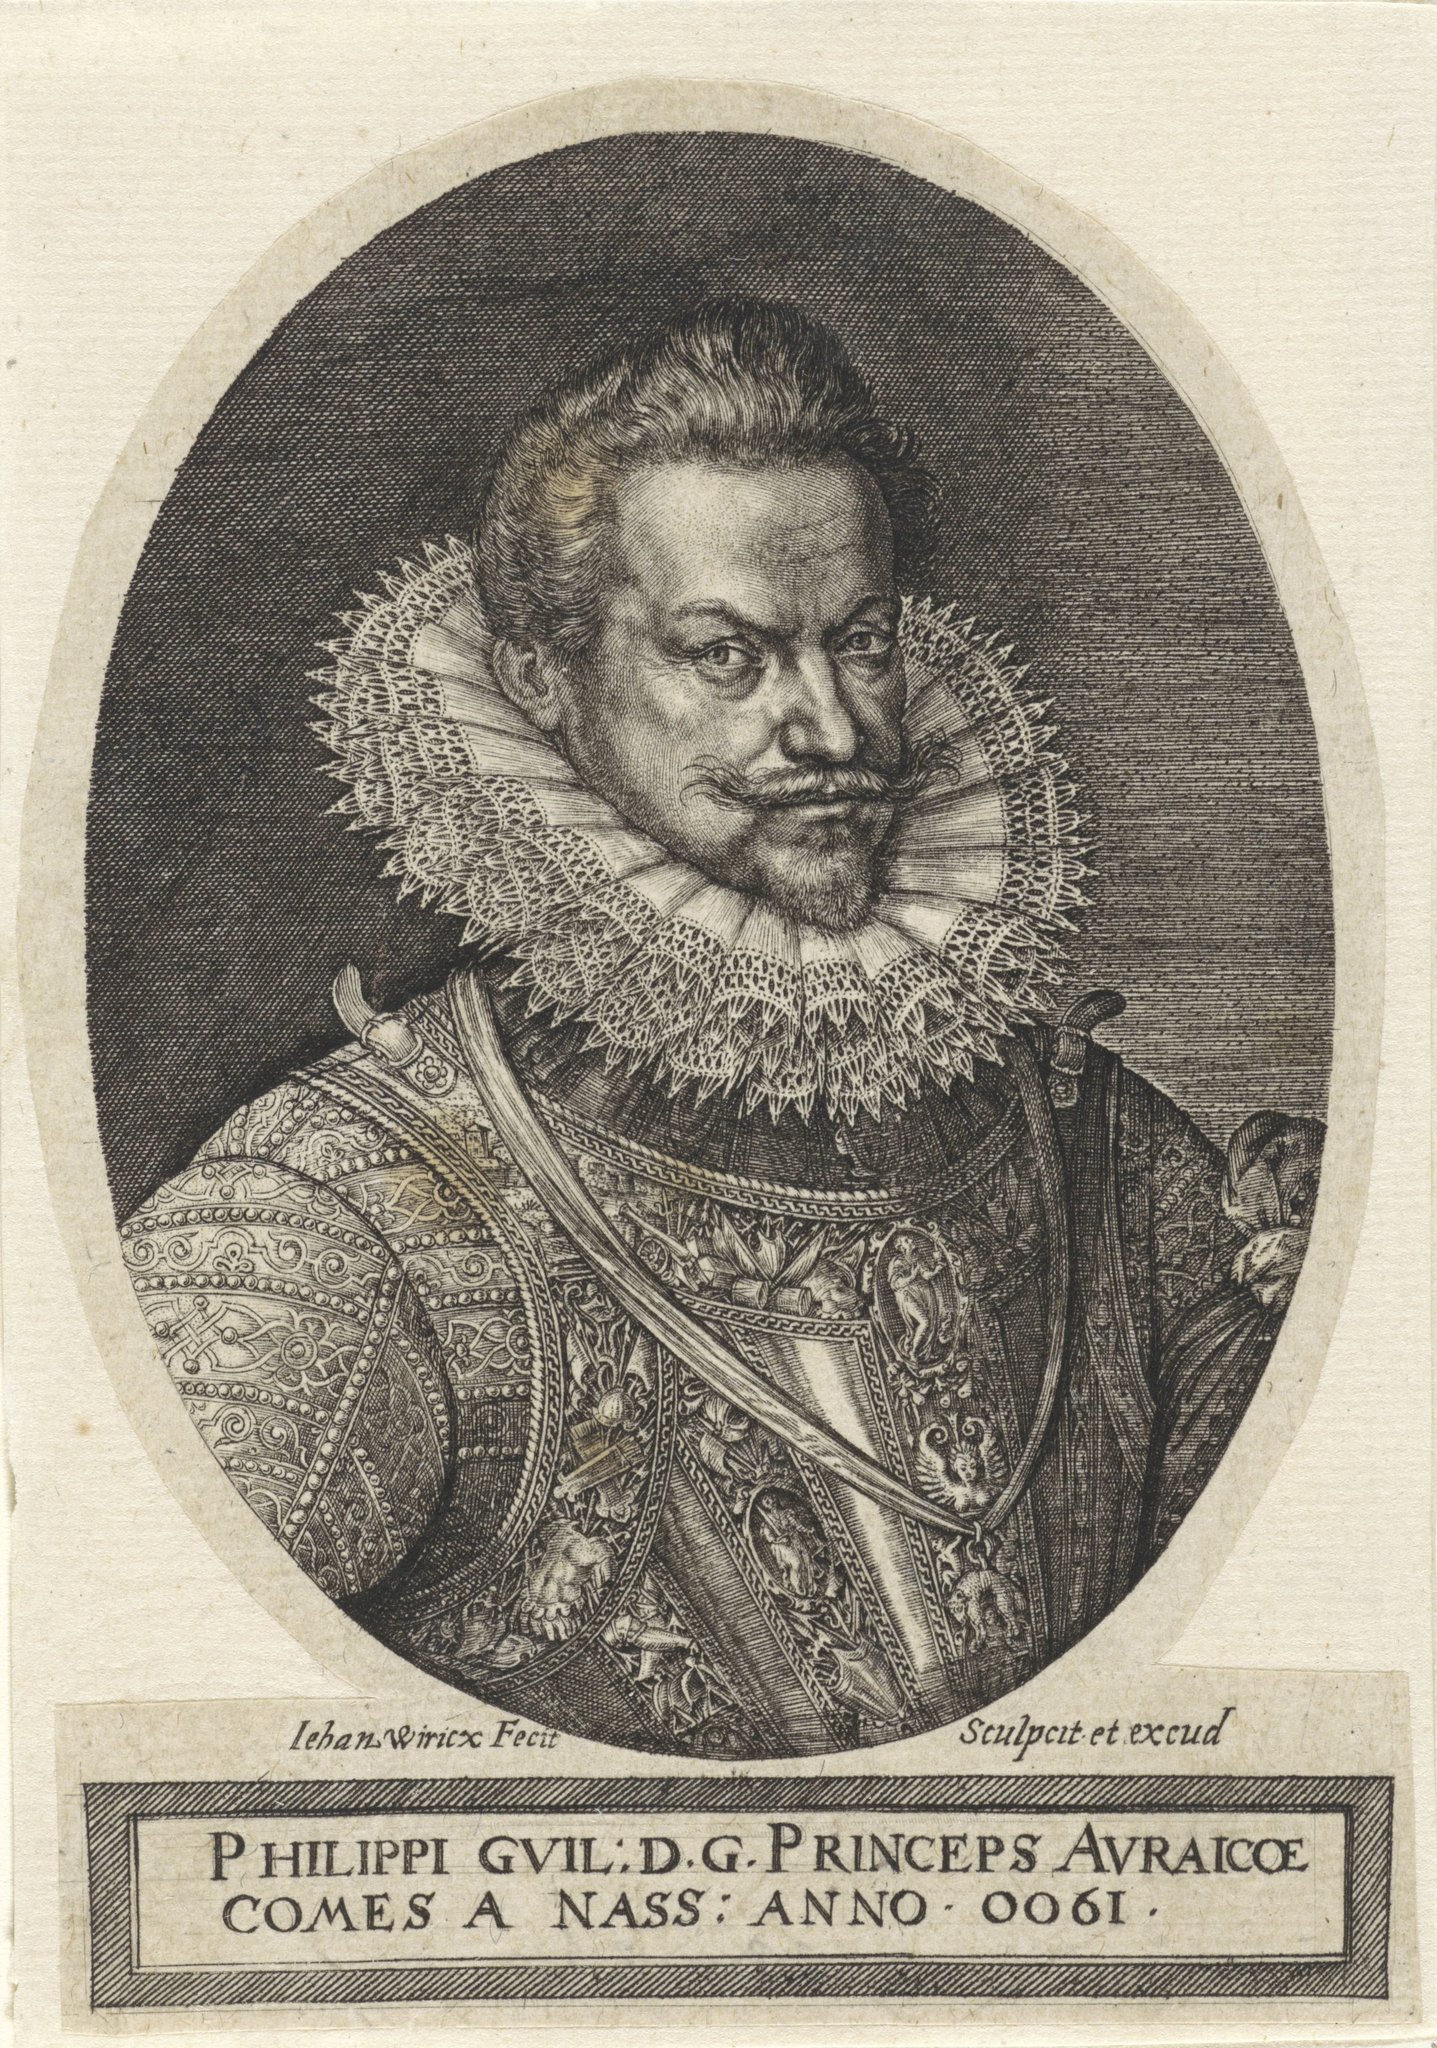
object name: print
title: Portret van Filips Willem, prins van Oranje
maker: johannes wierix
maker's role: draughtsman, print maker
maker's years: 1549-1618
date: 1600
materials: paper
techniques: engraving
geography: antwerp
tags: bruges, filips willem (prins van oranje), neck-gear ~ clothing (with name) (+ men's clothes), armour, knighthood order of the golden fleece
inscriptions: collector's mark: Lugt 2228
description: Hij draagt een harnas en een lint met de Orde van het Gulden Vlies. In het kader een tweeregelig onderschrift in het Latijn.